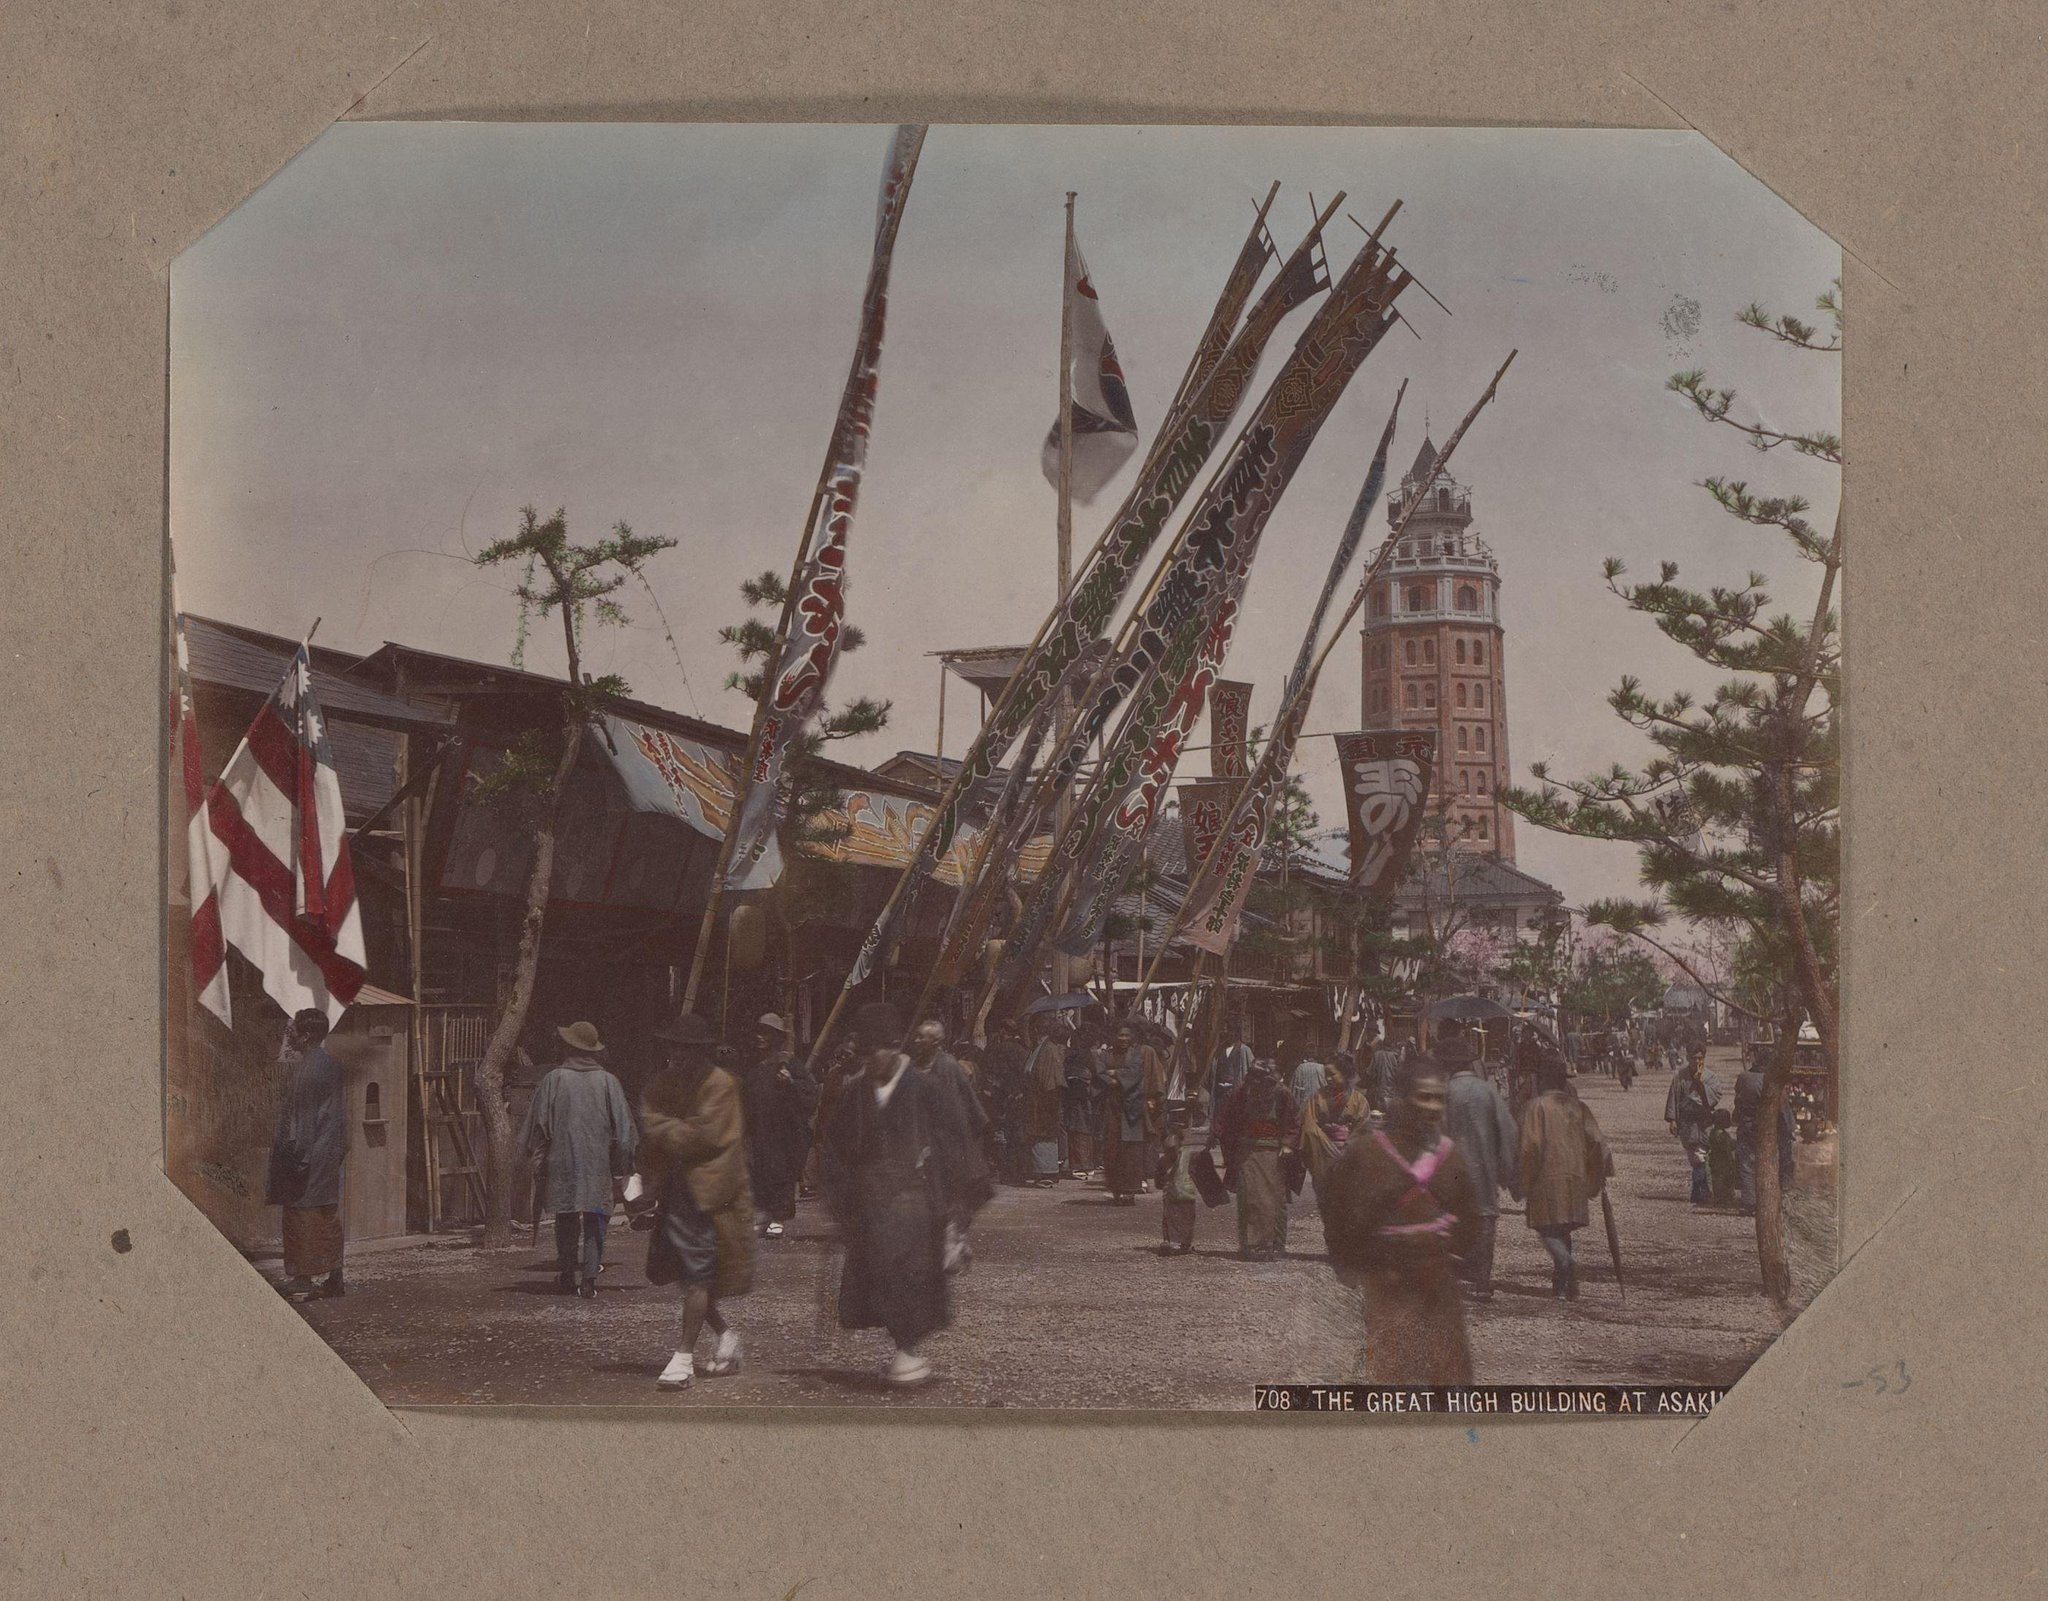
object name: album leaf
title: Straat in Akakusa inTokyo, Japan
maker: kusakabe kimbei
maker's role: fotograaf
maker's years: 1841-1934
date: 1890-1903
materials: paper, photographic support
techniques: albumen print, hand coloring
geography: tokyo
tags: street (+ city(-scape) with figures, staffage)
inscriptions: inscription: ‘708 The Great High Building at Akakusa Tokio’